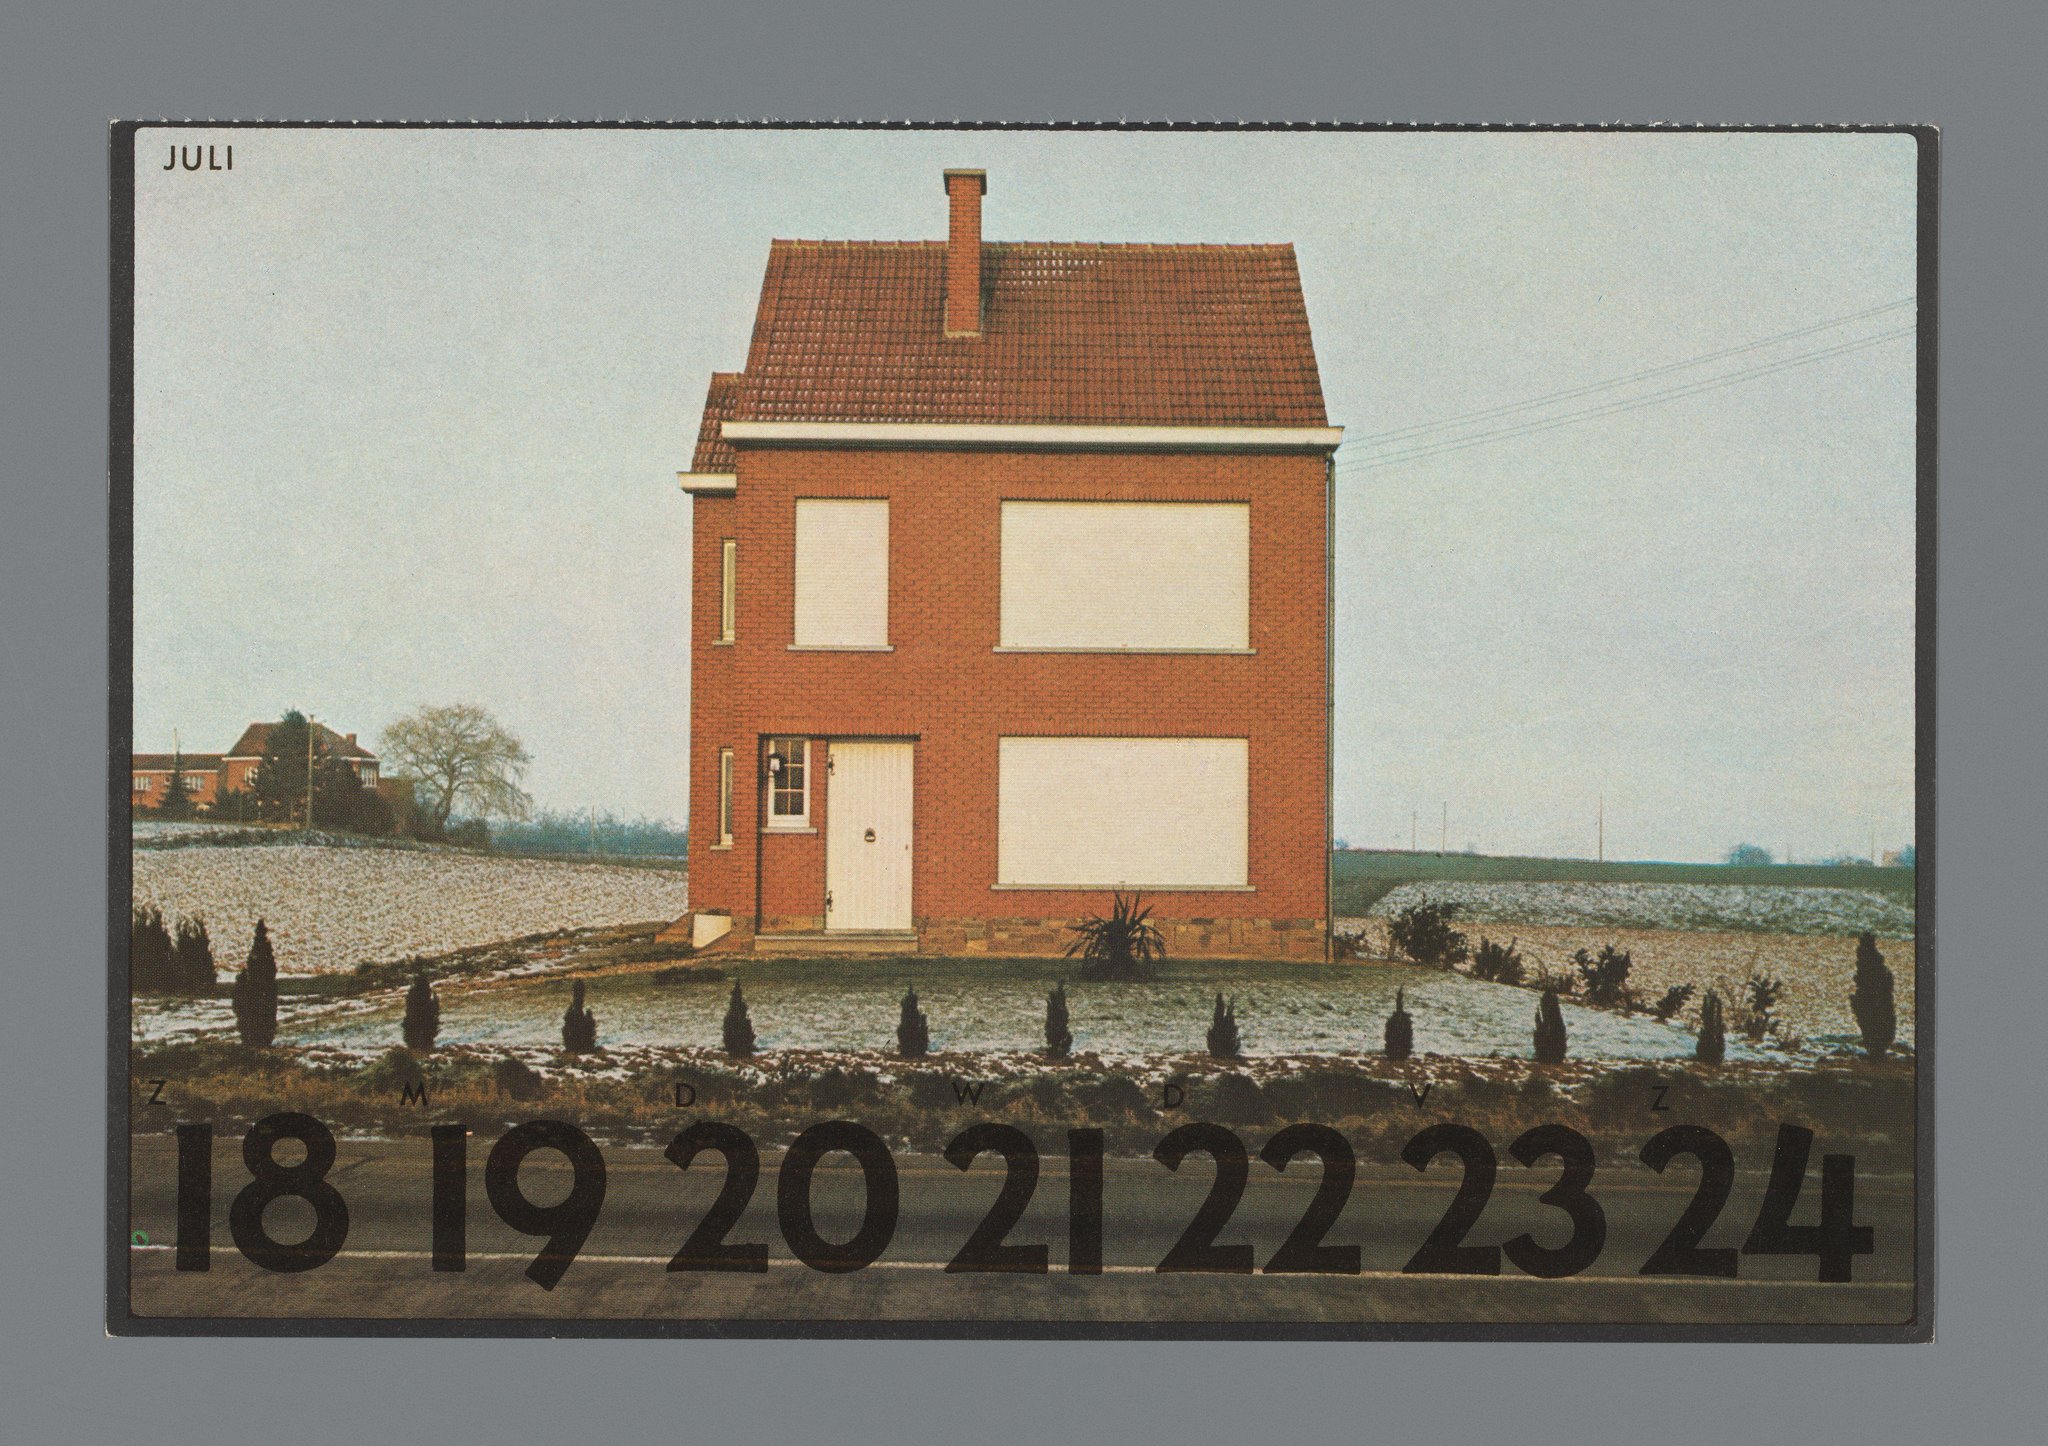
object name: photograph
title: België. Huizen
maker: Anonymous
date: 1900-1950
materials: paper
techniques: offset printed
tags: belgium